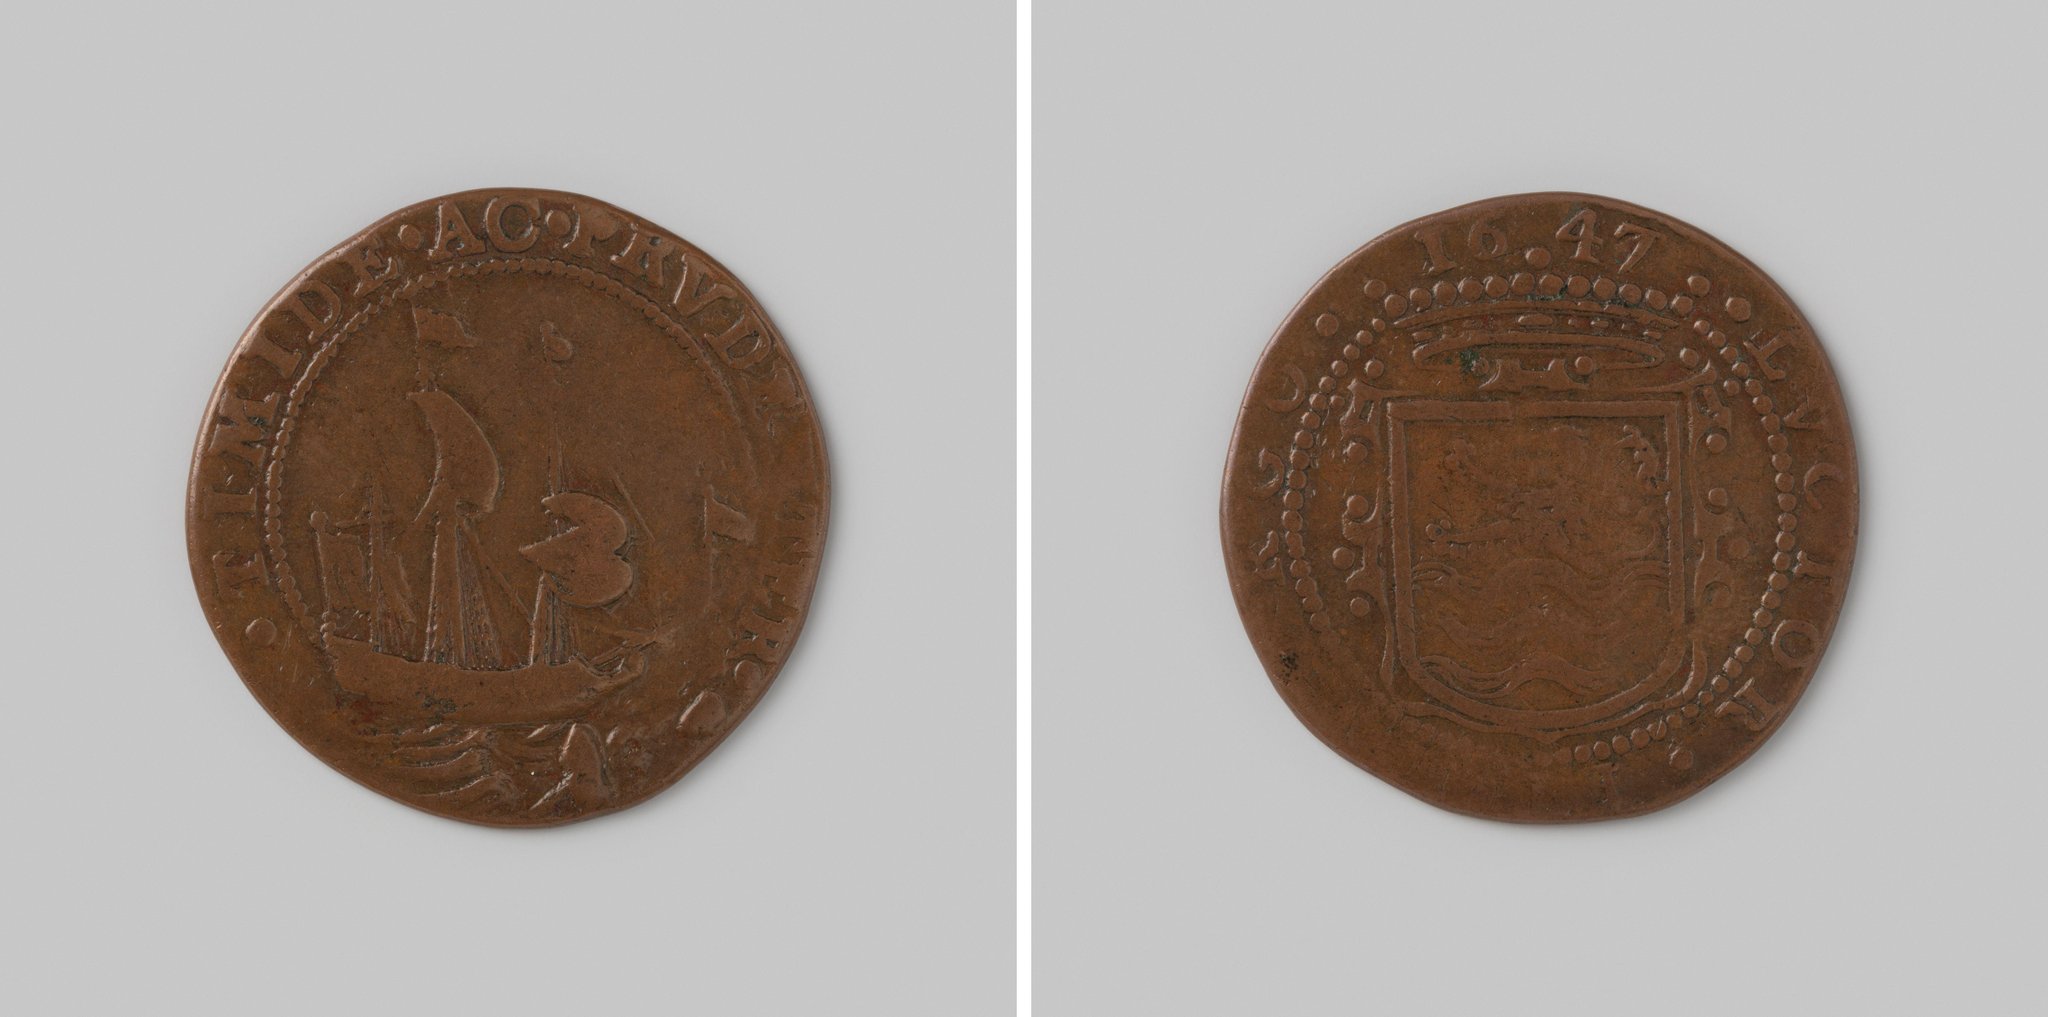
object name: history medal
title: Rekenpenning voor Zeeland op de onzekere uitslag van de vredesonderhandelingen 1647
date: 1647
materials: copper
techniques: striking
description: Koperen penning, op de voorzijde een zeilschip tussen rotsen, met omschrift, op de keerzijde het gekroonde wapenschild van Zeeland met omschrift.